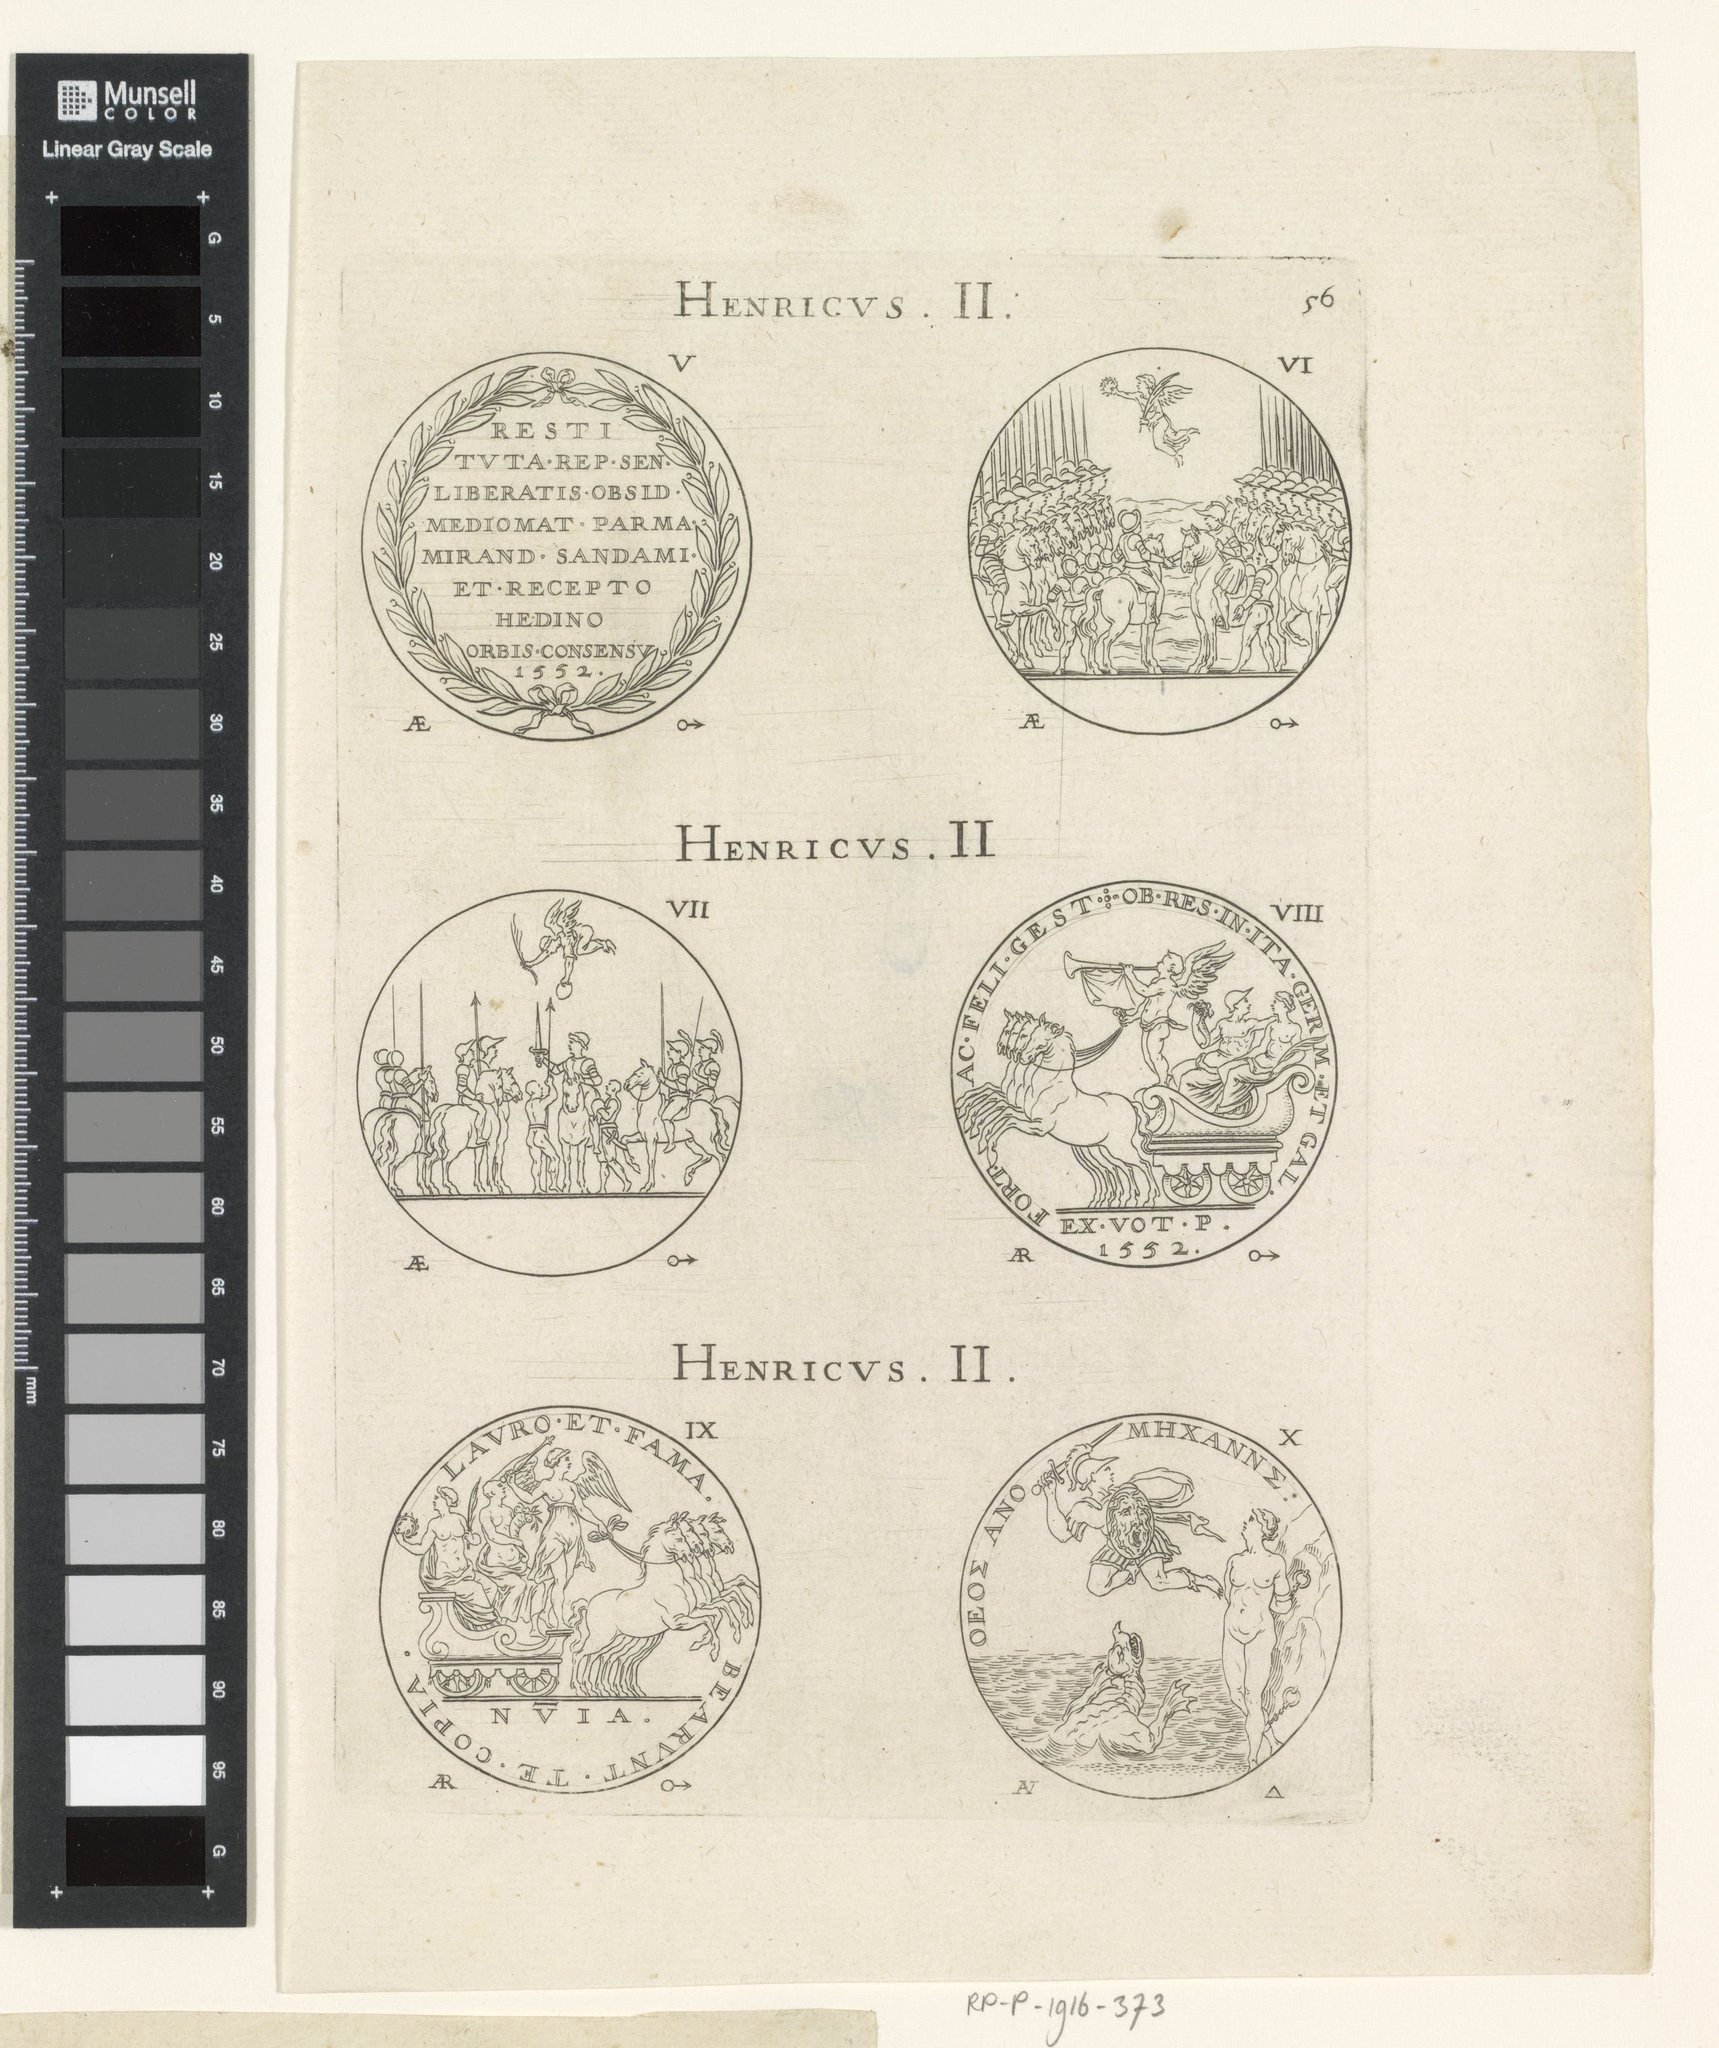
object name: print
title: Zes penningen van Henricus II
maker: Anonymous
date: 1650-1750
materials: paper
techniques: engraving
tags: medal (considered as a piece of sculpture, regardless of its specific function)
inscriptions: collector's mark: Lugt 2228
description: Zes genummerde penningen van Henricus II. Linksboven een munt met het jaartal 1552. Rechtsonder Perseus en Andromeda. Rechtsboven genummerd: 56.